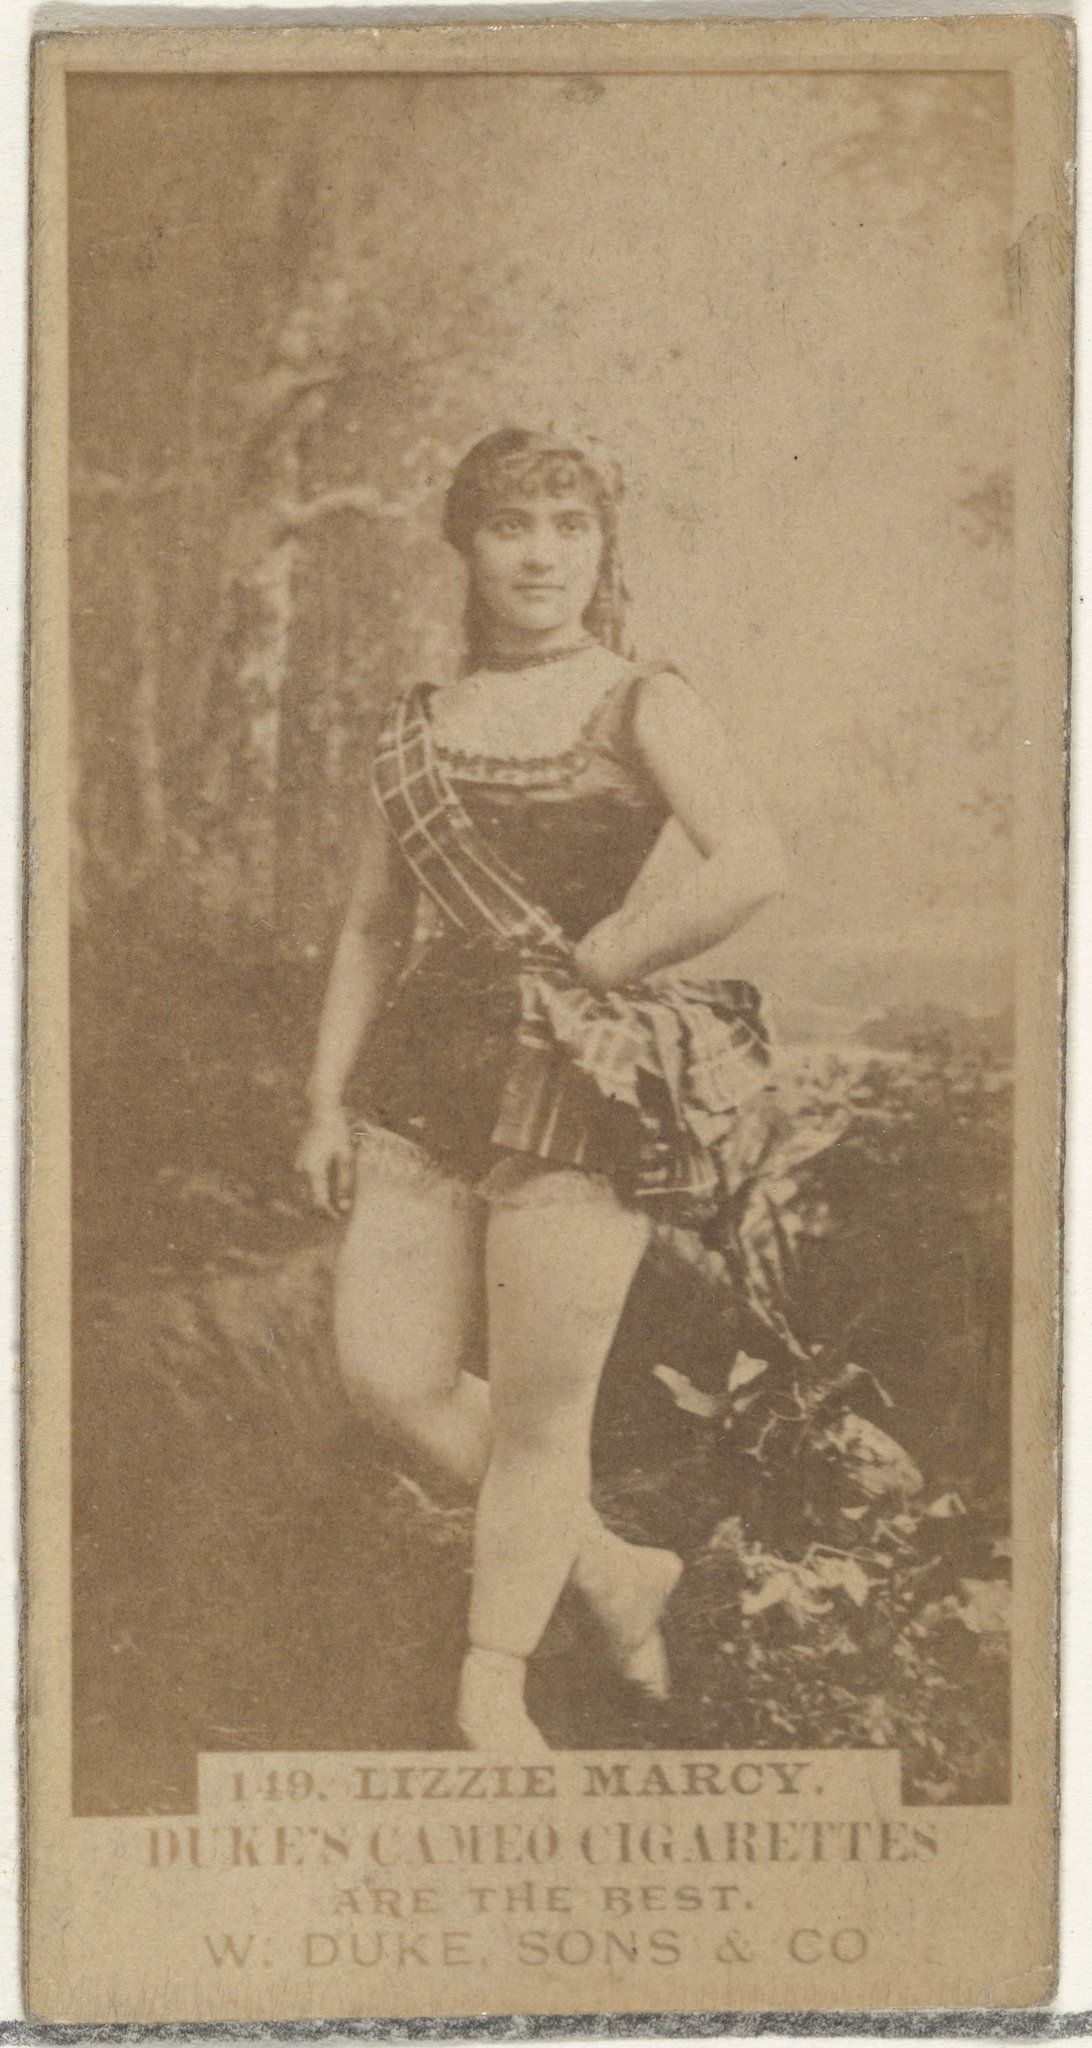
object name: photograph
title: Card Number 149, Lizzie Marcy, from the Actors and Actresses series (N145-5) issued by Duke Sons & Co. to promote Cameo Cigarettes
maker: w. duke, sons & co.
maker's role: publisher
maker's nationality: american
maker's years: 1870-1920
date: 1880-1889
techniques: albumen silver print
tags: portraits,women,actresses